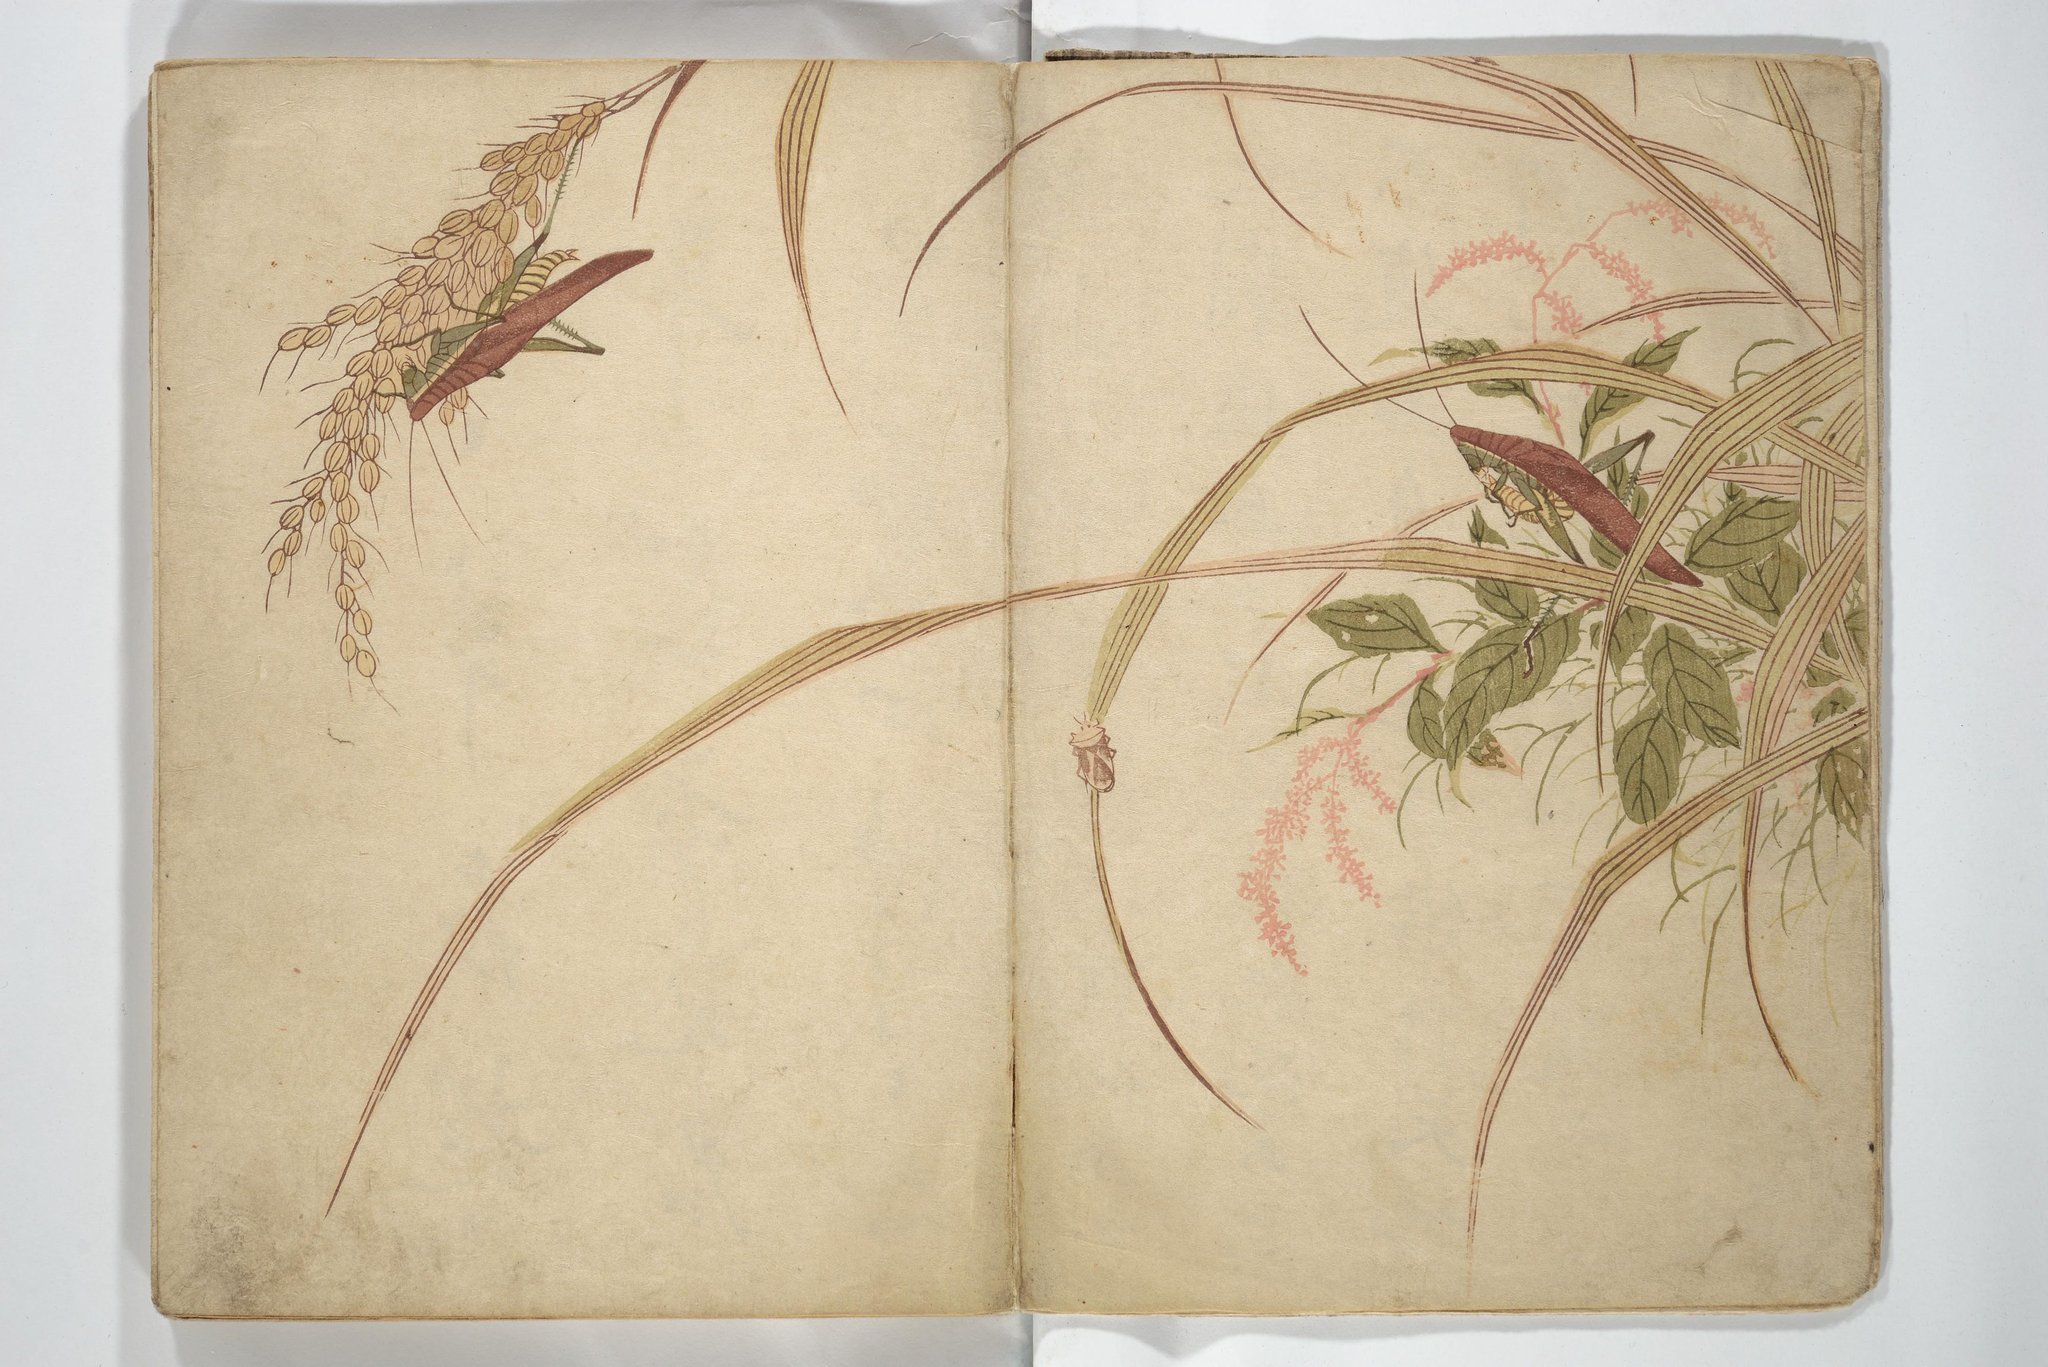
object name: illustrated book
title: Shunkei Picture Album (Shunkei gafu) 春渓画譜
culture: japanese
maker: mori shunkei 森春渓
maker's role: artist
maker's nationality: japanese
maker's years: 1800-1820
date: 1820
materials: ink, paper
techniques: woodblock print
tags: insects,plants,leaves